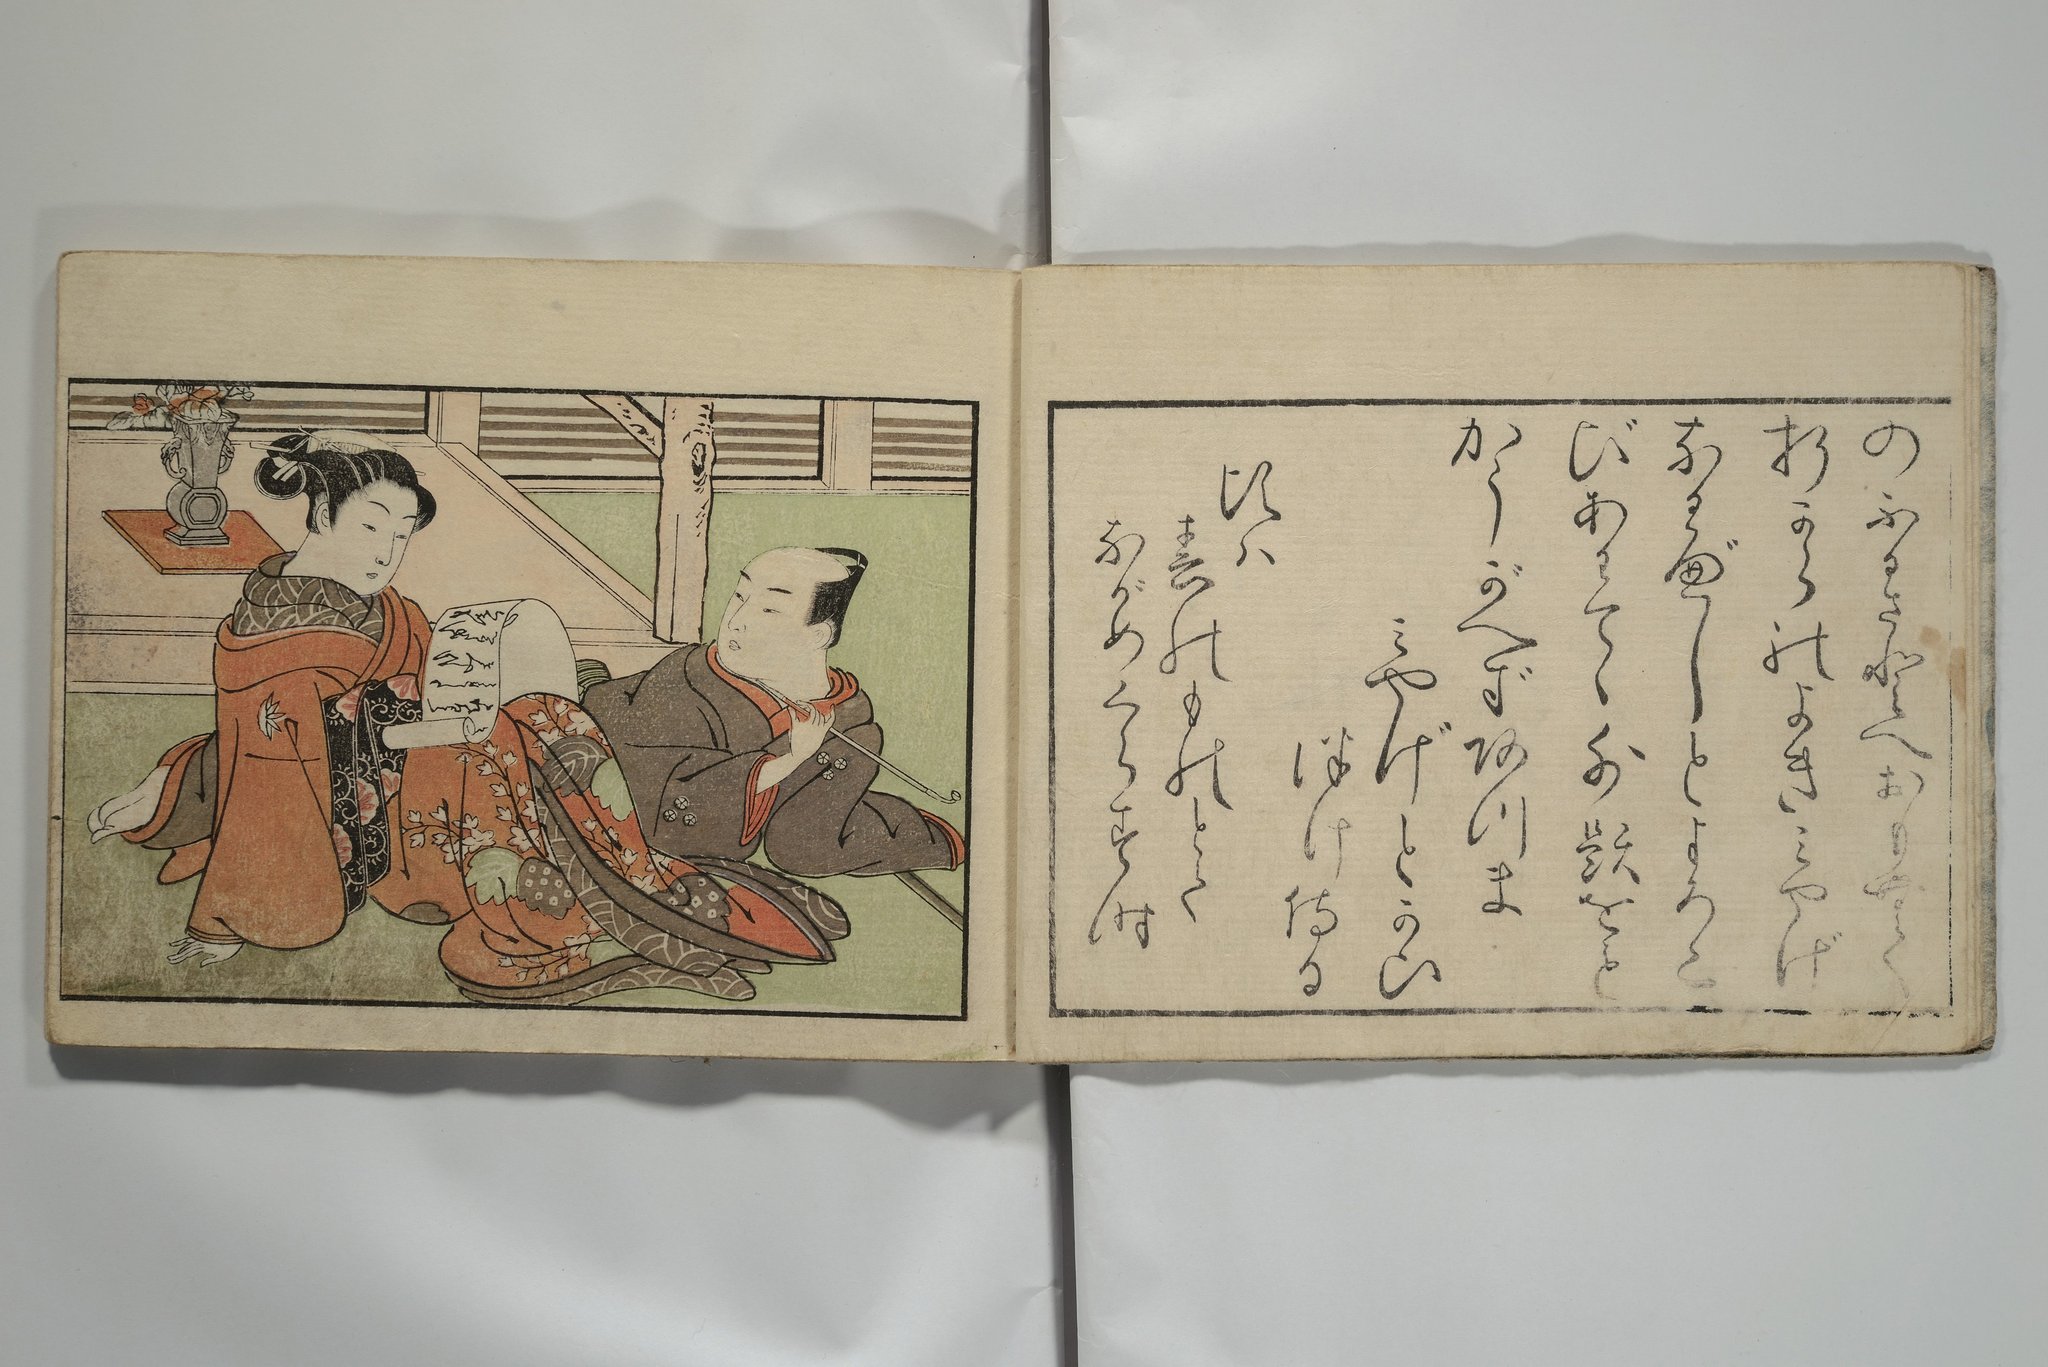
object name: illustrated book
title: Picture Book of the Eternal Pines (Ehon chiyo no matsu)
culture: japanese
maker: suzuki harunobu 鈴木春信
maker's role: artist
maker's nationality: japanese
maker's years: 1725-1770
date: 1767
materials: ink, paper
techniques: woodblock print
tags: men,women